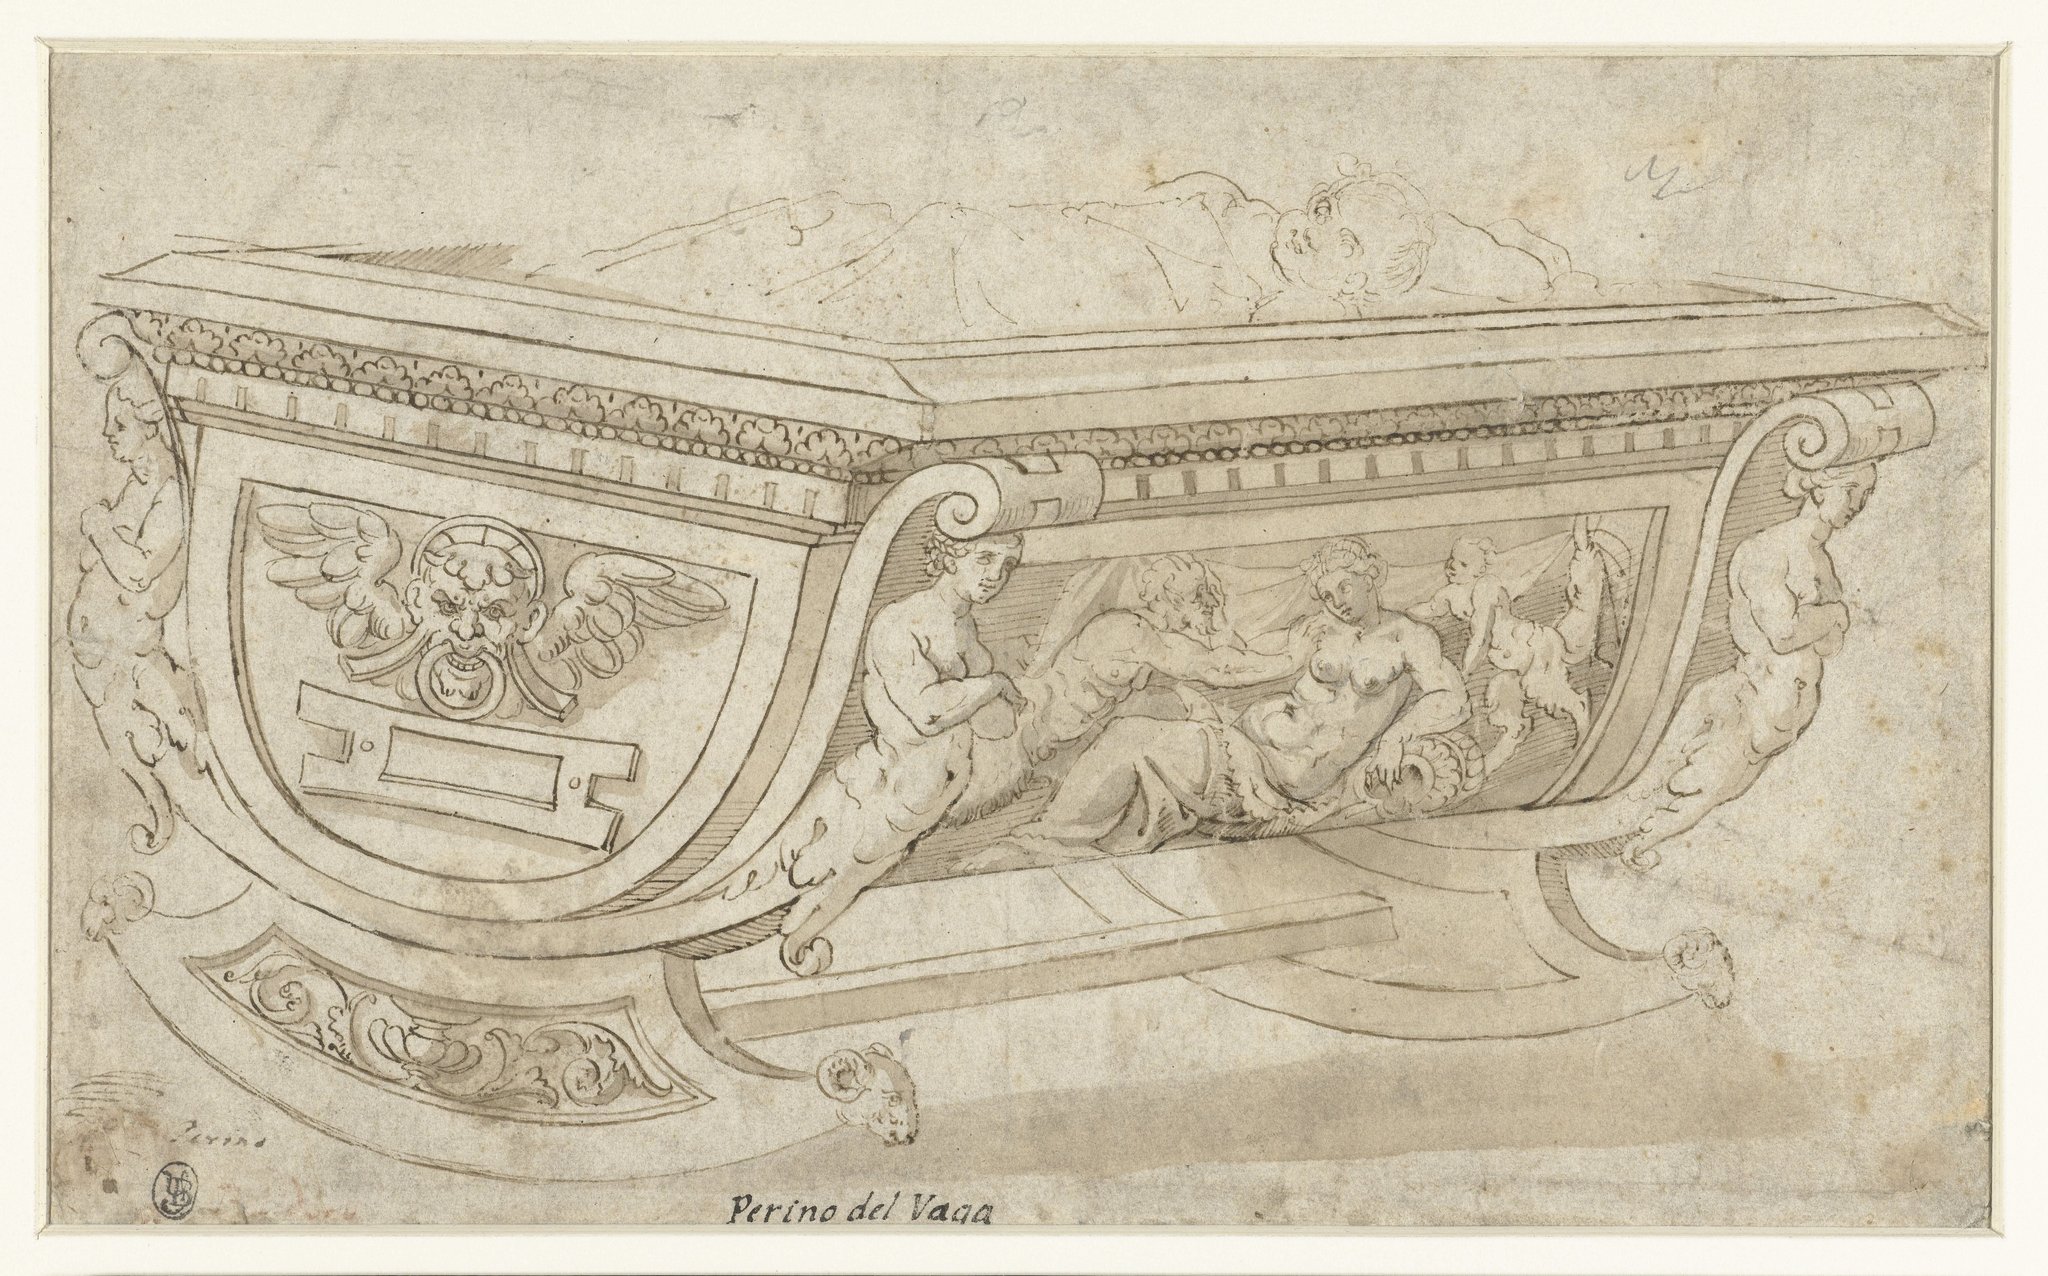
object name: design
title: Ontwerp voor een houten wieg op twee schommelpoten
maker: perino del vaga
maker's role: draughtsman, painter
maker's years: 1501-1547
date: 1530-1620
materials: ink, paper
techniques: brush, pen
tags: cradle, crib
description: Wieg met een voorstelling van een nimf en een sater.